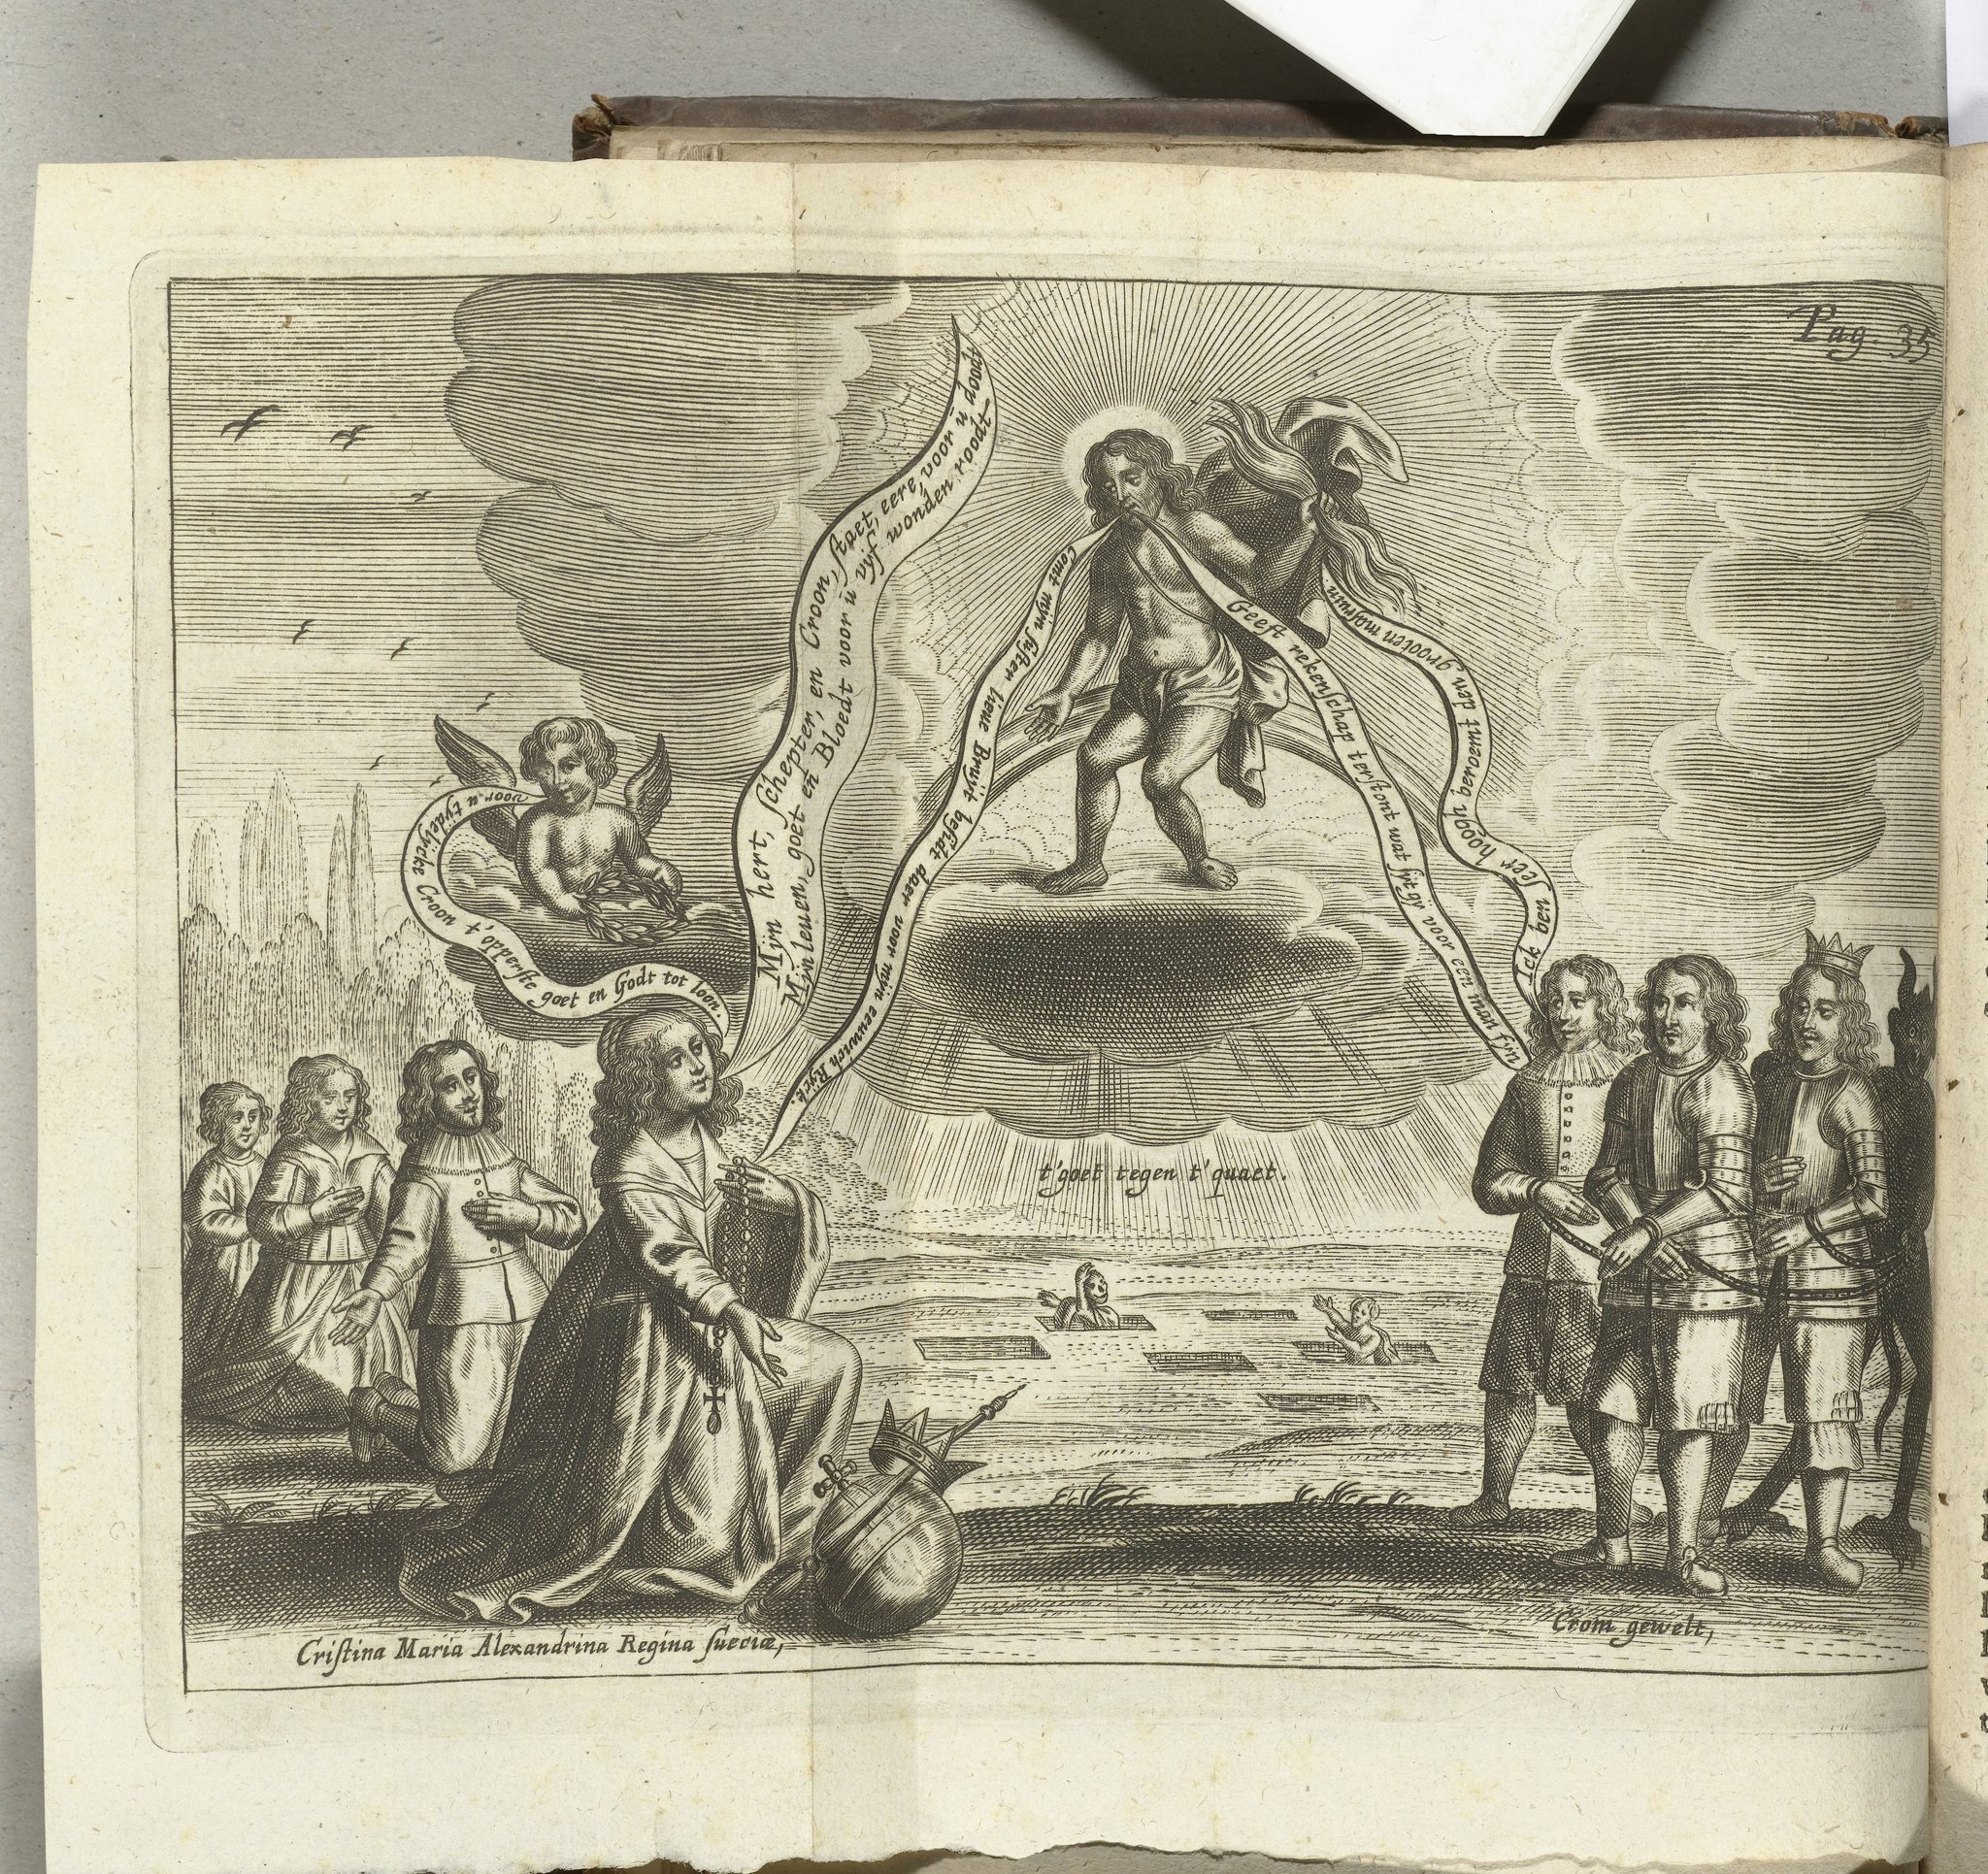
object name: print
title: Spotprent op Cromwell en Mazarin, 1656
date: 1656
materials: paper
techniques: engraving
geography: cologne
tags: rome, christina (koningin van zweden), oliver cromwell, political caricatures and satires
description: Spotprent op Oliver Cromwell en kardinaal Mazarin, 1656. Rechts Cromwell en Mazarin geketend door de Duivel. Links knielt koningin Christina van Zweden en geeft symbolen van de aardse macht aan Christus. Op een wolk spreekt Christus de vorsten toe. In de voorstelling opschriften in het Nederlands. Gemerkt rechtsboven: Pag. 35.